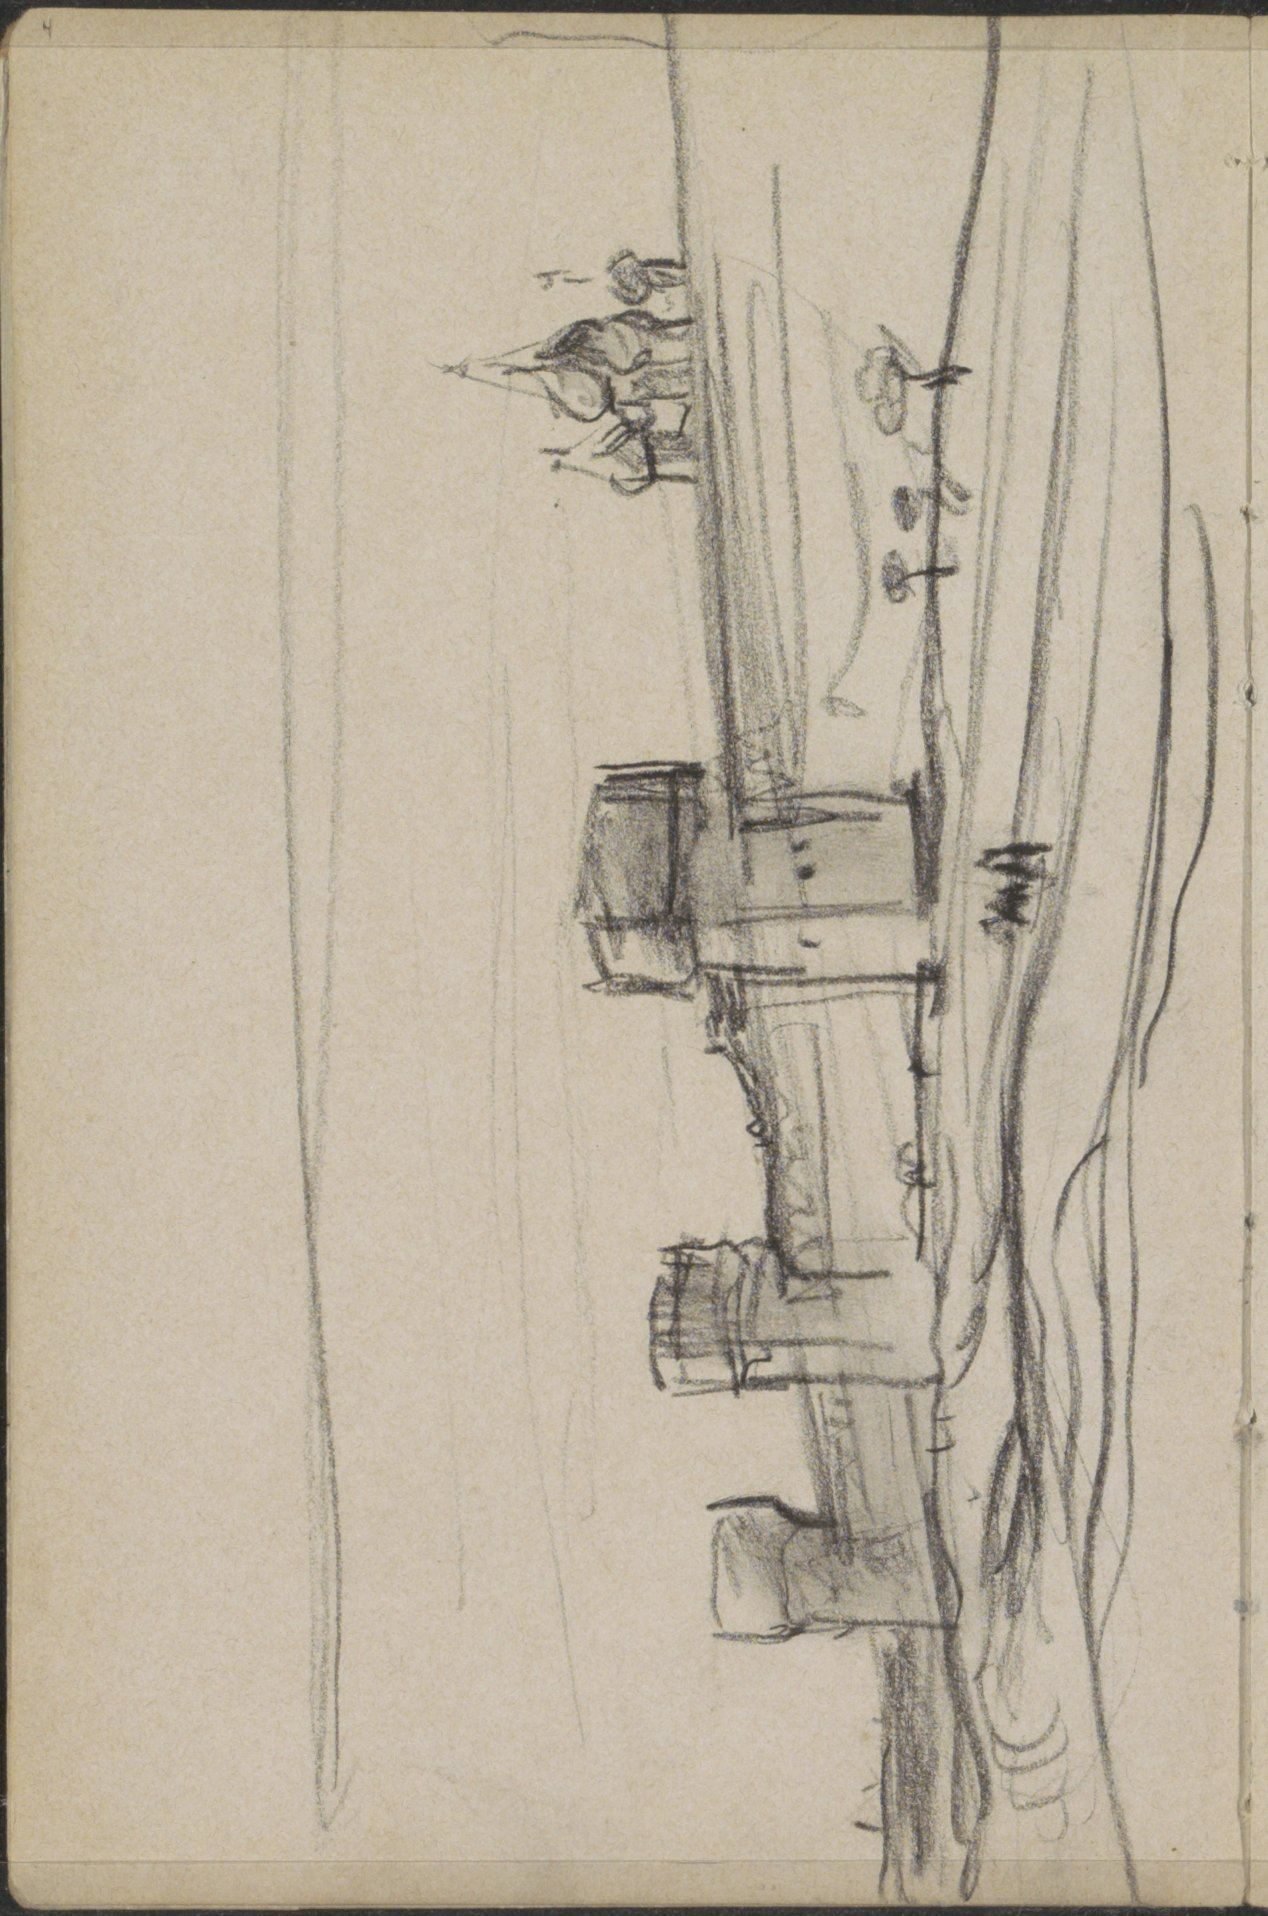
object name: sketchbook leaf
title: Verdedigingsmuur met drie torens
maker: marius bauer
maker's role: draughtsman, print maker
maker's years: 1867-1932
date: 1896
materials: chalk, paper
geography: moscow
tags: russian orthodox church, towers ~ fortified city, walls ~ fortified city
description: Mogelijk een deel van de muur om het Kremlin. Op de achtergrond de koepels van een gebouw, mogelijk de Prokovkathedraal aan het Rode Plein. Pagina 4 uit een schetsboek met 45 bladen.